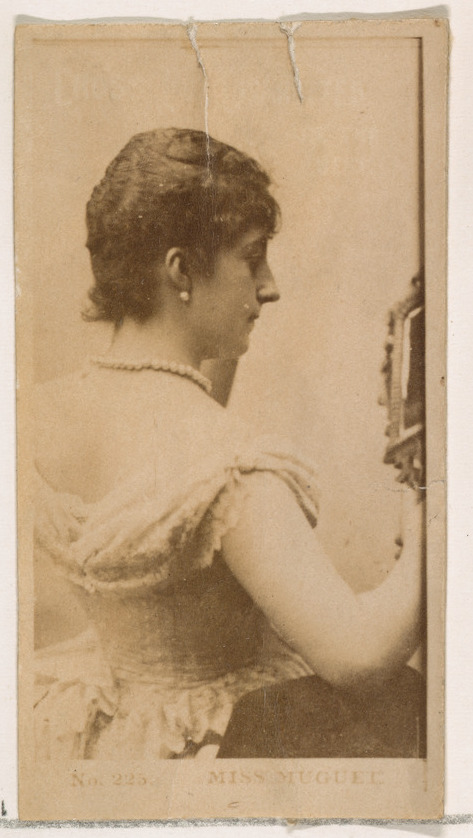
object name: print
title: Card Number 225, Miss Muguel, from the Actors and Actresses series (N145-2) issued by Duke Sons & Co. to promote Cross Cut Cigarettes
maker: w. duke, sons & co.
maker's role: publisher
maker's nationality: american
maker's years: 1870-1920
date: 1880-1889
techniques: albumen silver print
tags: women,actresses